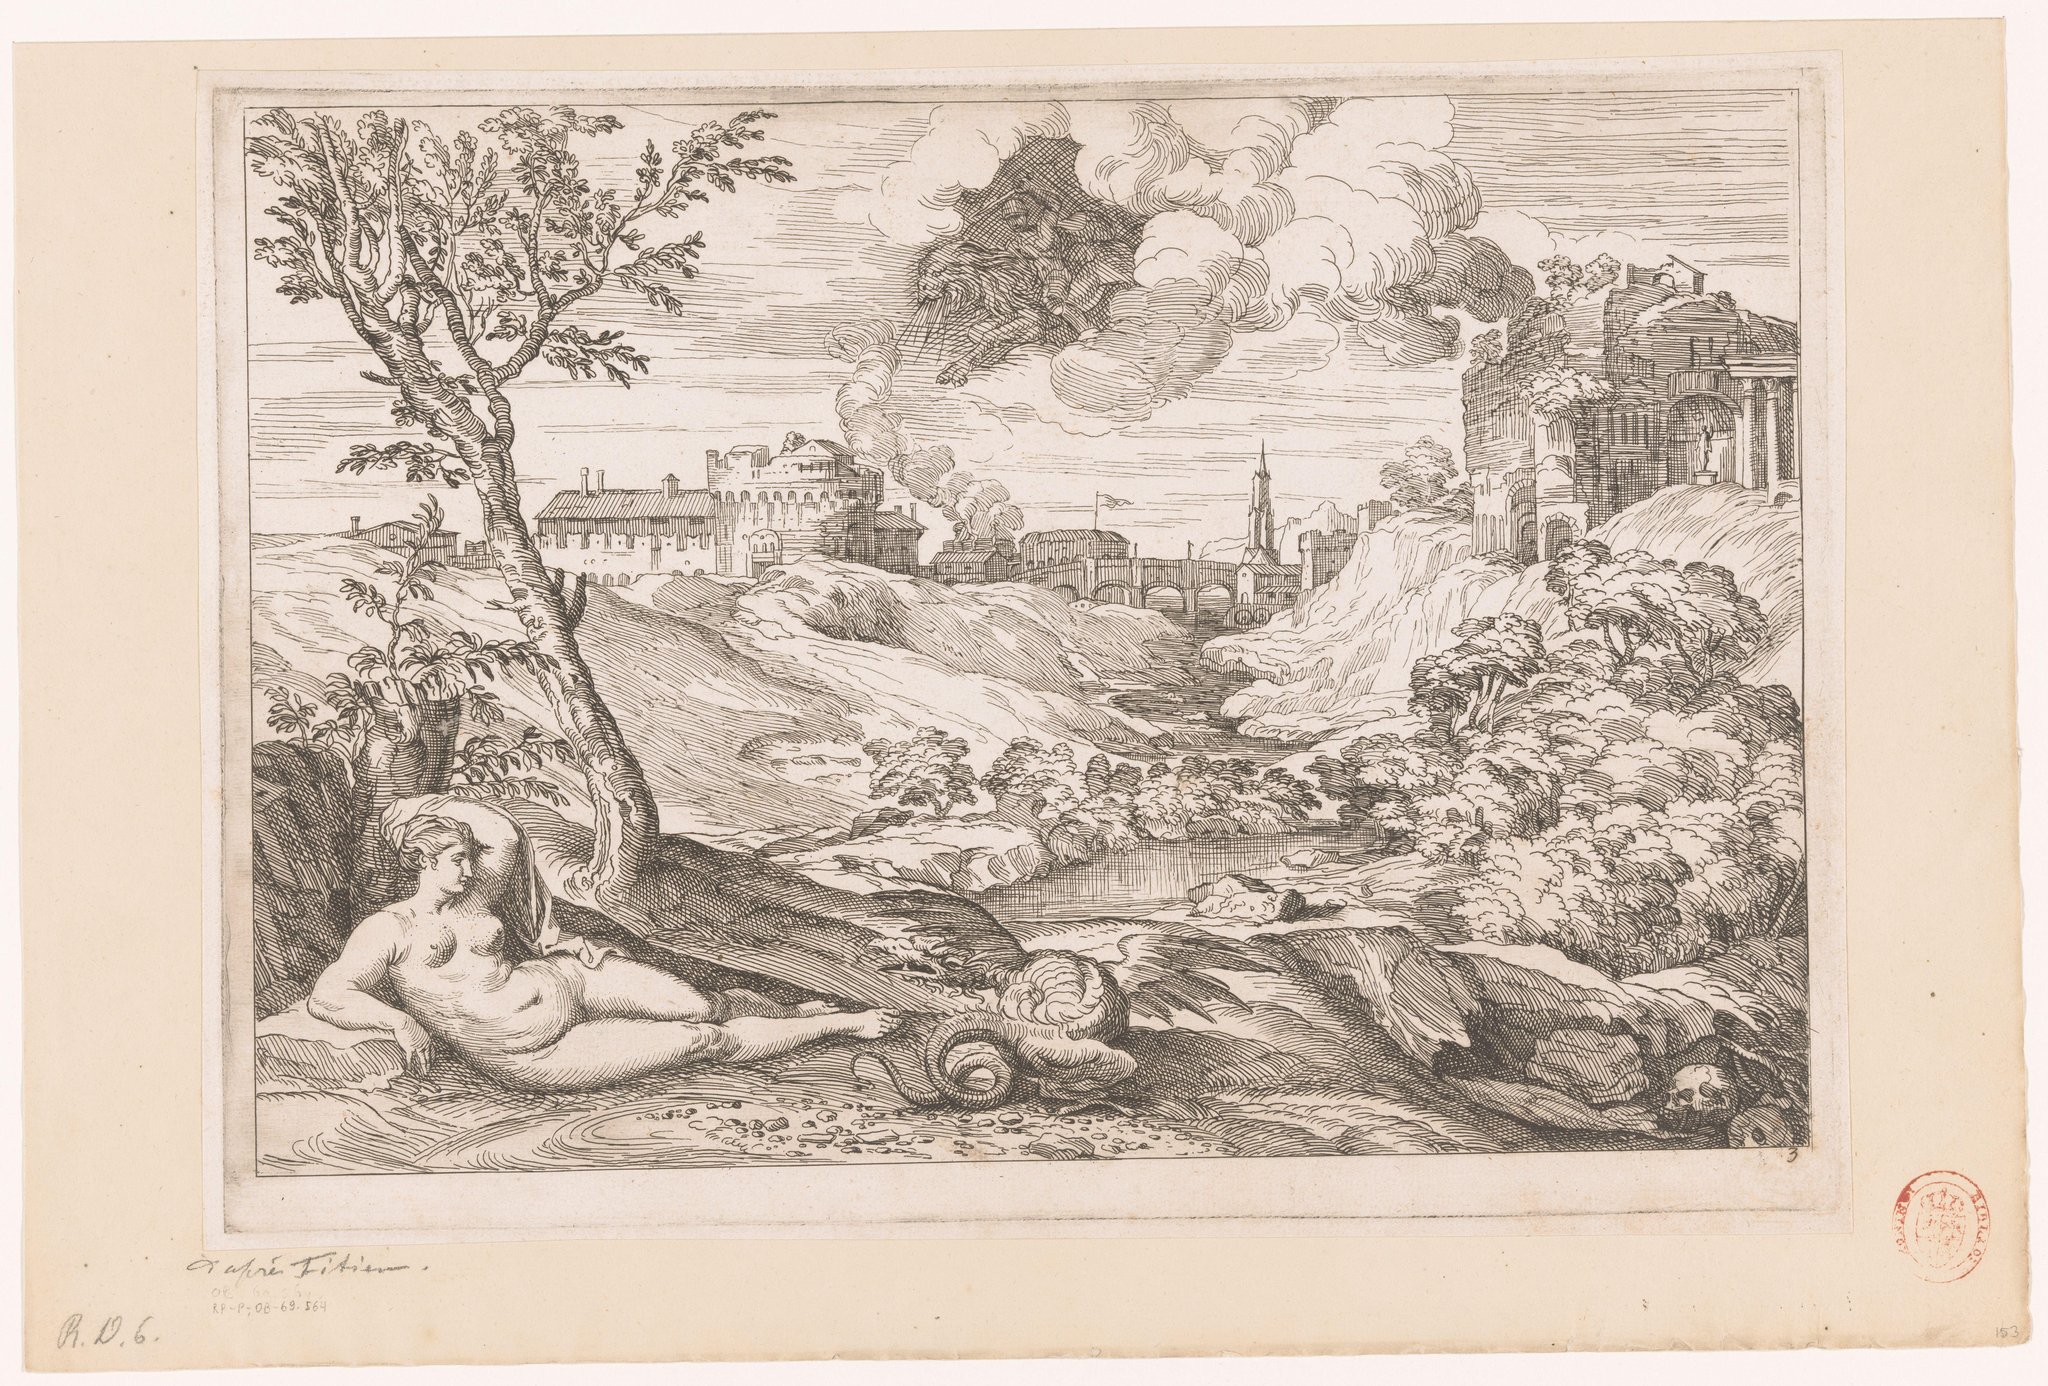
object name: print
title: Landschap met Andromeda bewaakt door de draak en Perseus aanvliegend in een wolk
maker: charles macé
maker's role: draughtsman, print maker, sculptor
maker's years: 1631-1665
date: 1641-1665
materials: paper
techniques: etching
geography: france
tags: perseus and andromeda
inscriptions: number: ‘3’, collector's mark: Lugt 240